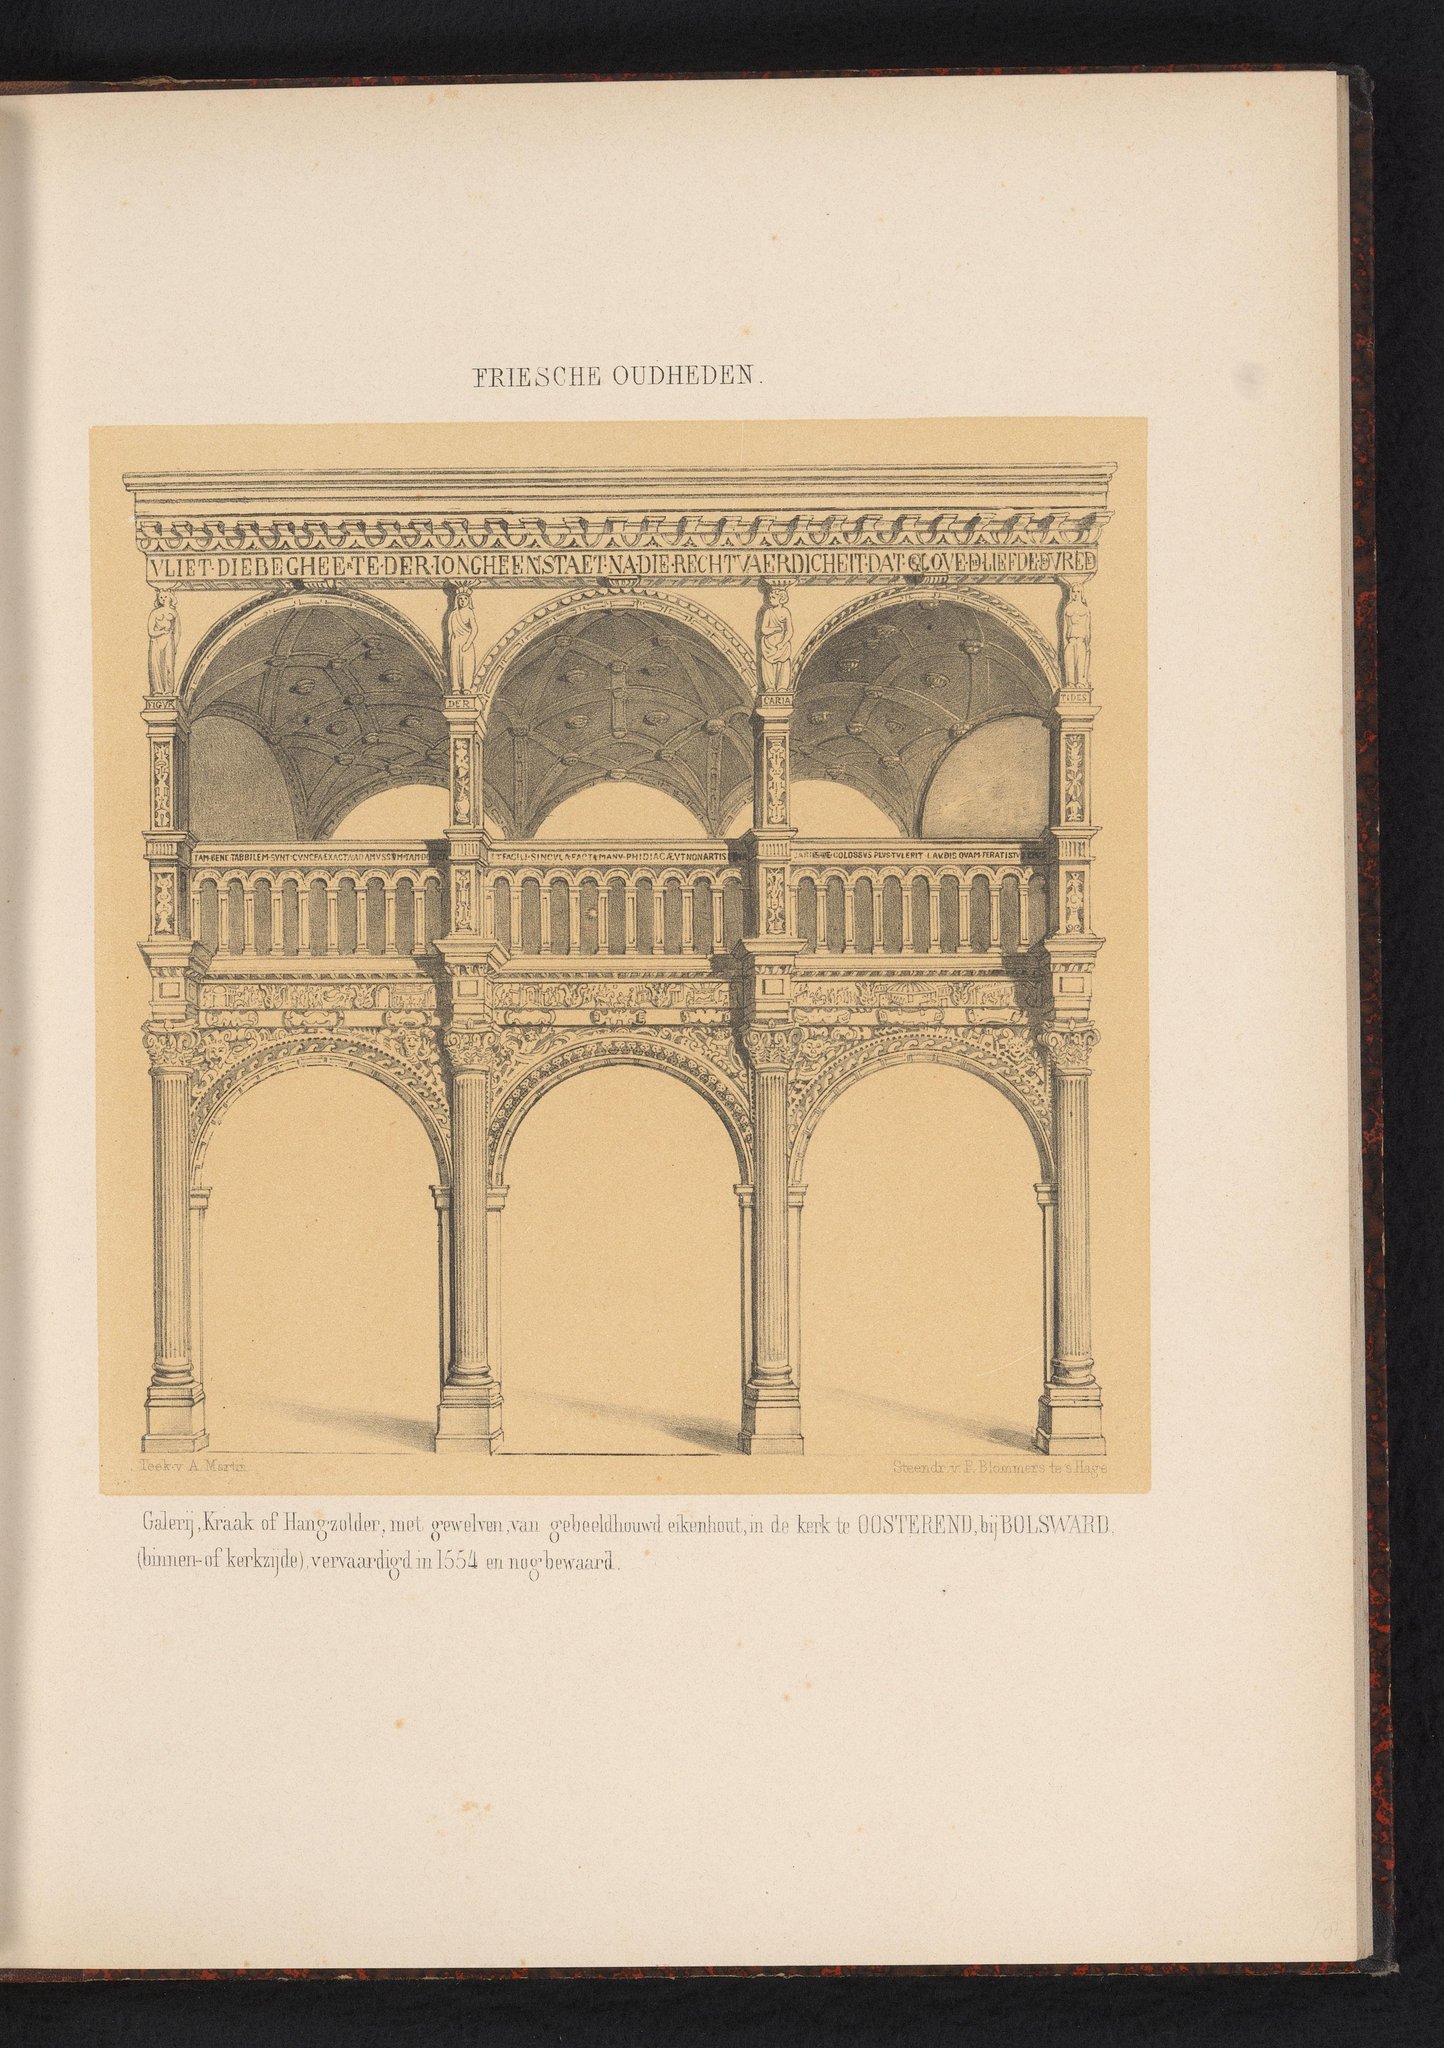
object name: print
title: Galerij in de kerk van Oosterend uit 1554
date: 1870-1875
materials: paper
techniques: lithograph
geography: the hague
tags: interior of church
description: Illustratie in: Friesche Oudheden. Afbeeldingen van merkwaardige voorwerpen van Wetenschap en Kunst, gevonden in de archieven, kerken, kasteelen, terpen enz. van Friesland, Leeuwarden 1875. Niet in Frederik Muller; door het RPK toegevoegd nummer.